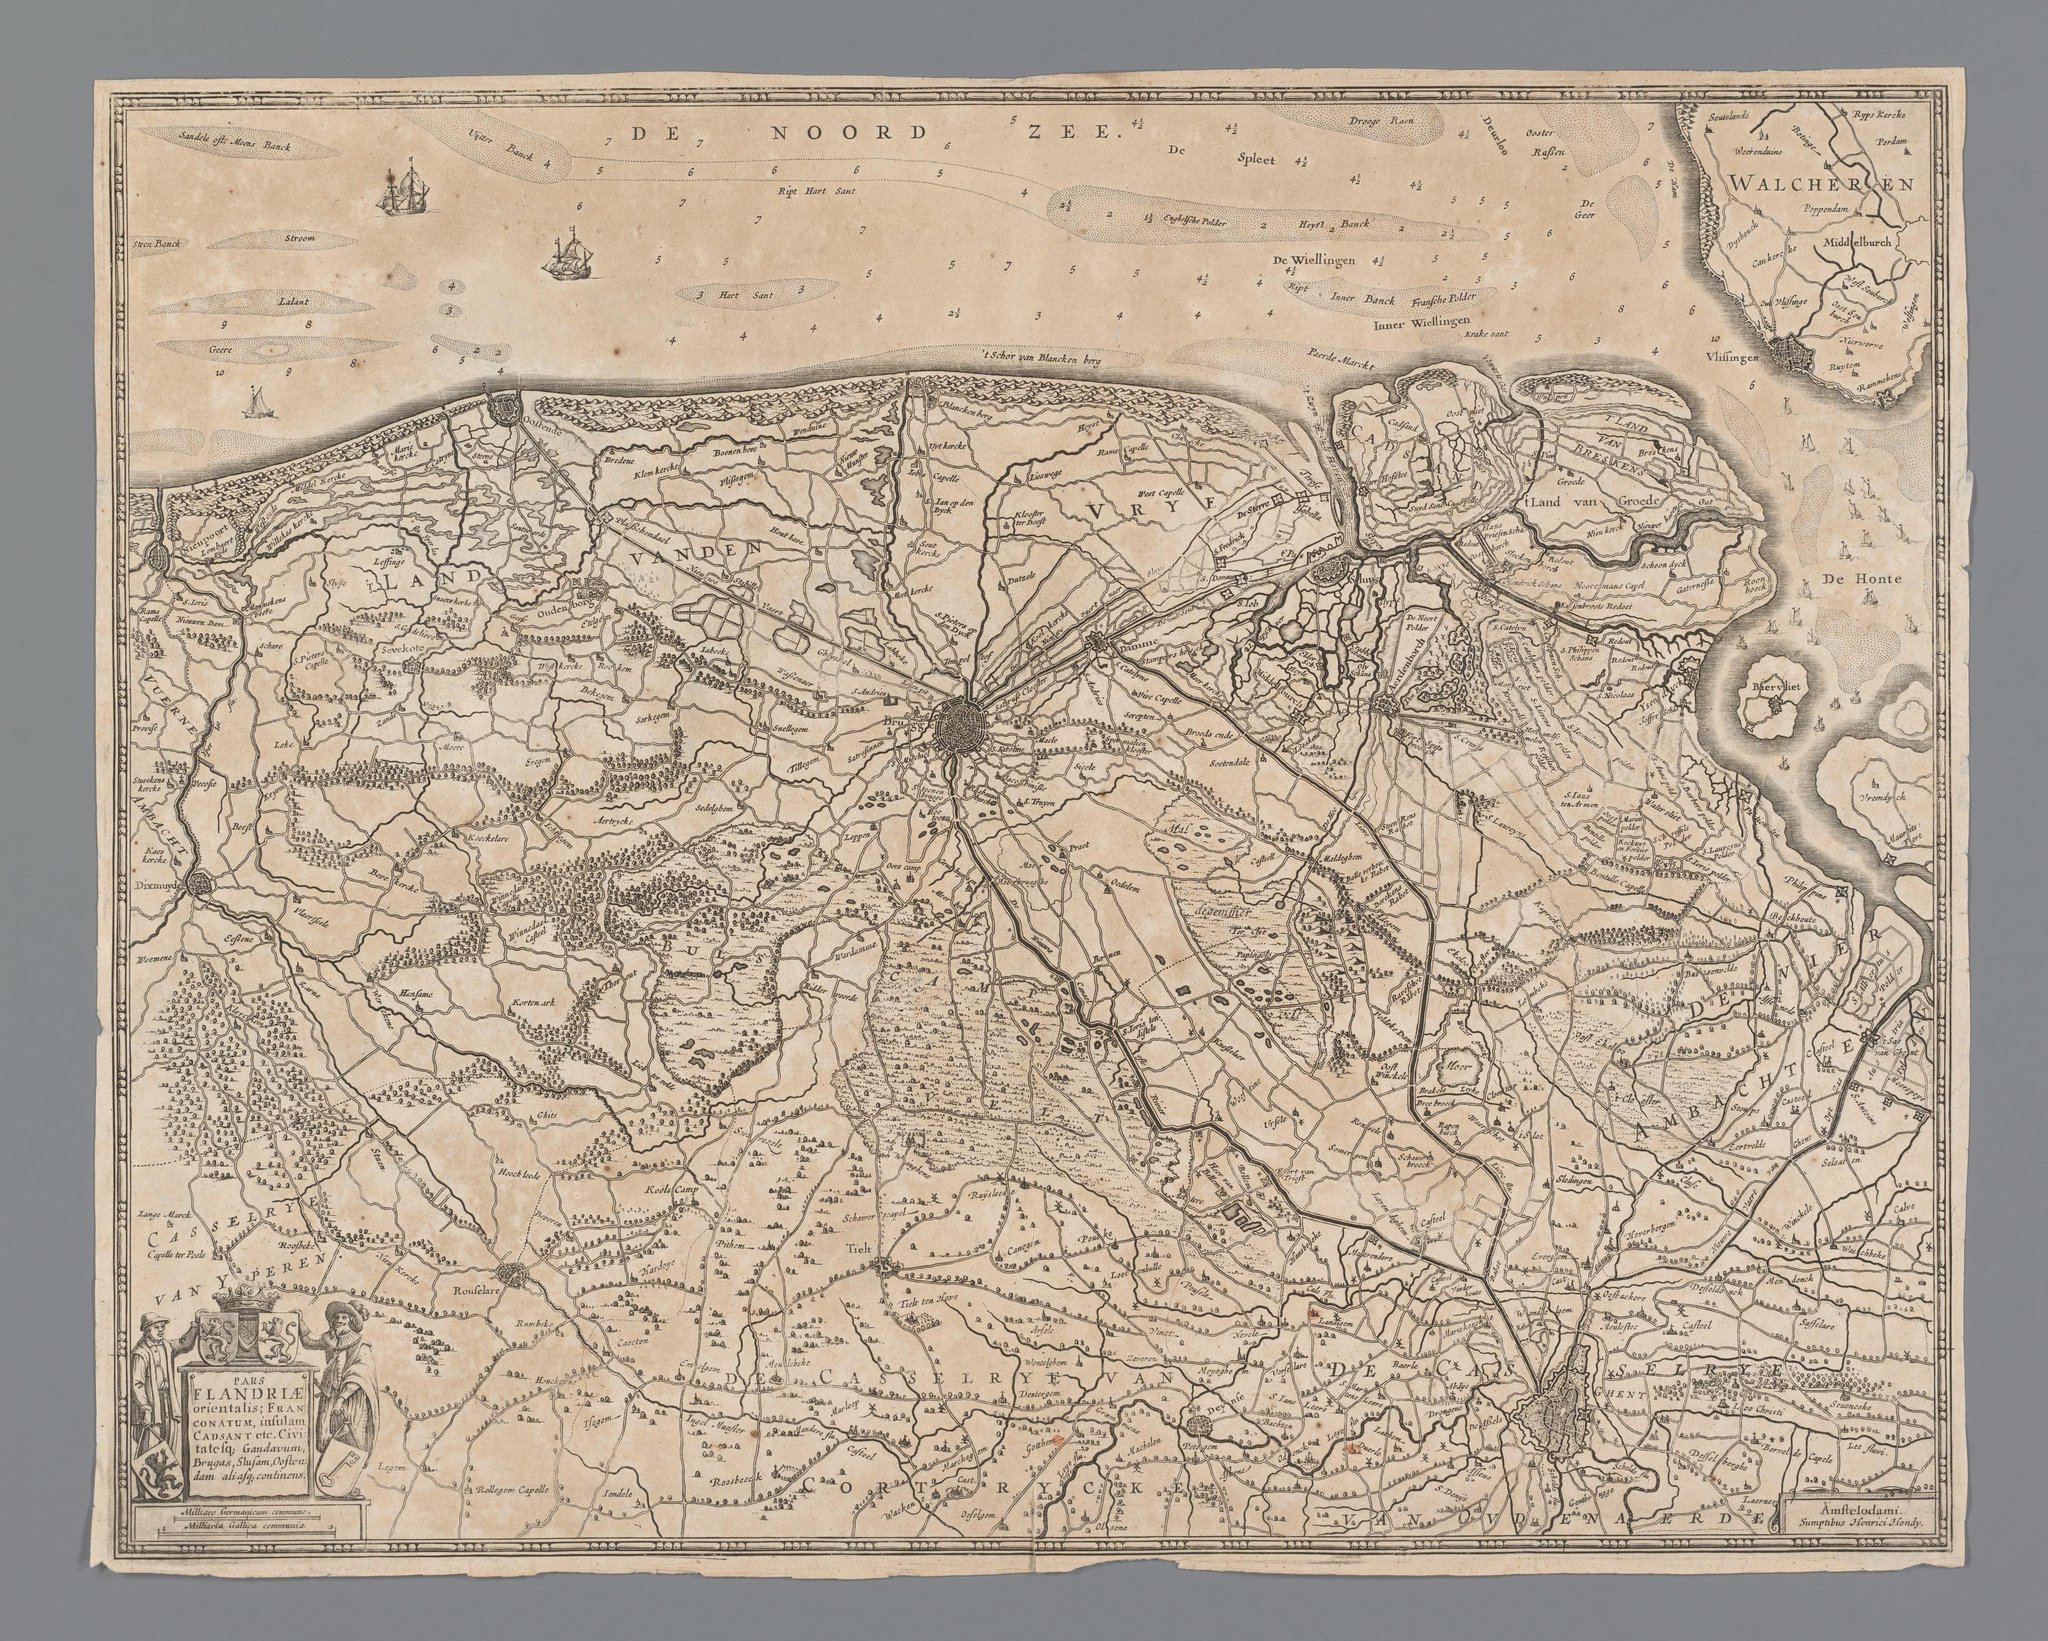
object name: print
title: Pars Flandriae orentalis; Franconatum, insulam Cadsant etc. (...)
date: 1633-1649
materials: paper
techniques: etching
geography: amsterdam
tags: maps of separate countries or regions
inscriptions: collector's mark: Lugt 2228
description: Kaart van het Brugse Vrije, het grootste burggraafschap van het graafschap Vlaanderen. Linksonder de titelcartouche met onderin twee schaalstokken: Milliare Germanicum commune / 2 Milliaria Gallica communia. Aan de linkerzijde van de cartouche een kostuumfiguur met het wapen van het graafschap Vlaanderen, in spiegelbeeld, en aan de rechterzijde een kostuumfiguur met waarschijnlijk het wapen van Oostende. Boven de cartouche twee wapenschilden met leeuw, mogelijk de wapenschilden van Brugge en, nogmaals, het graafschap Vlaanderen.